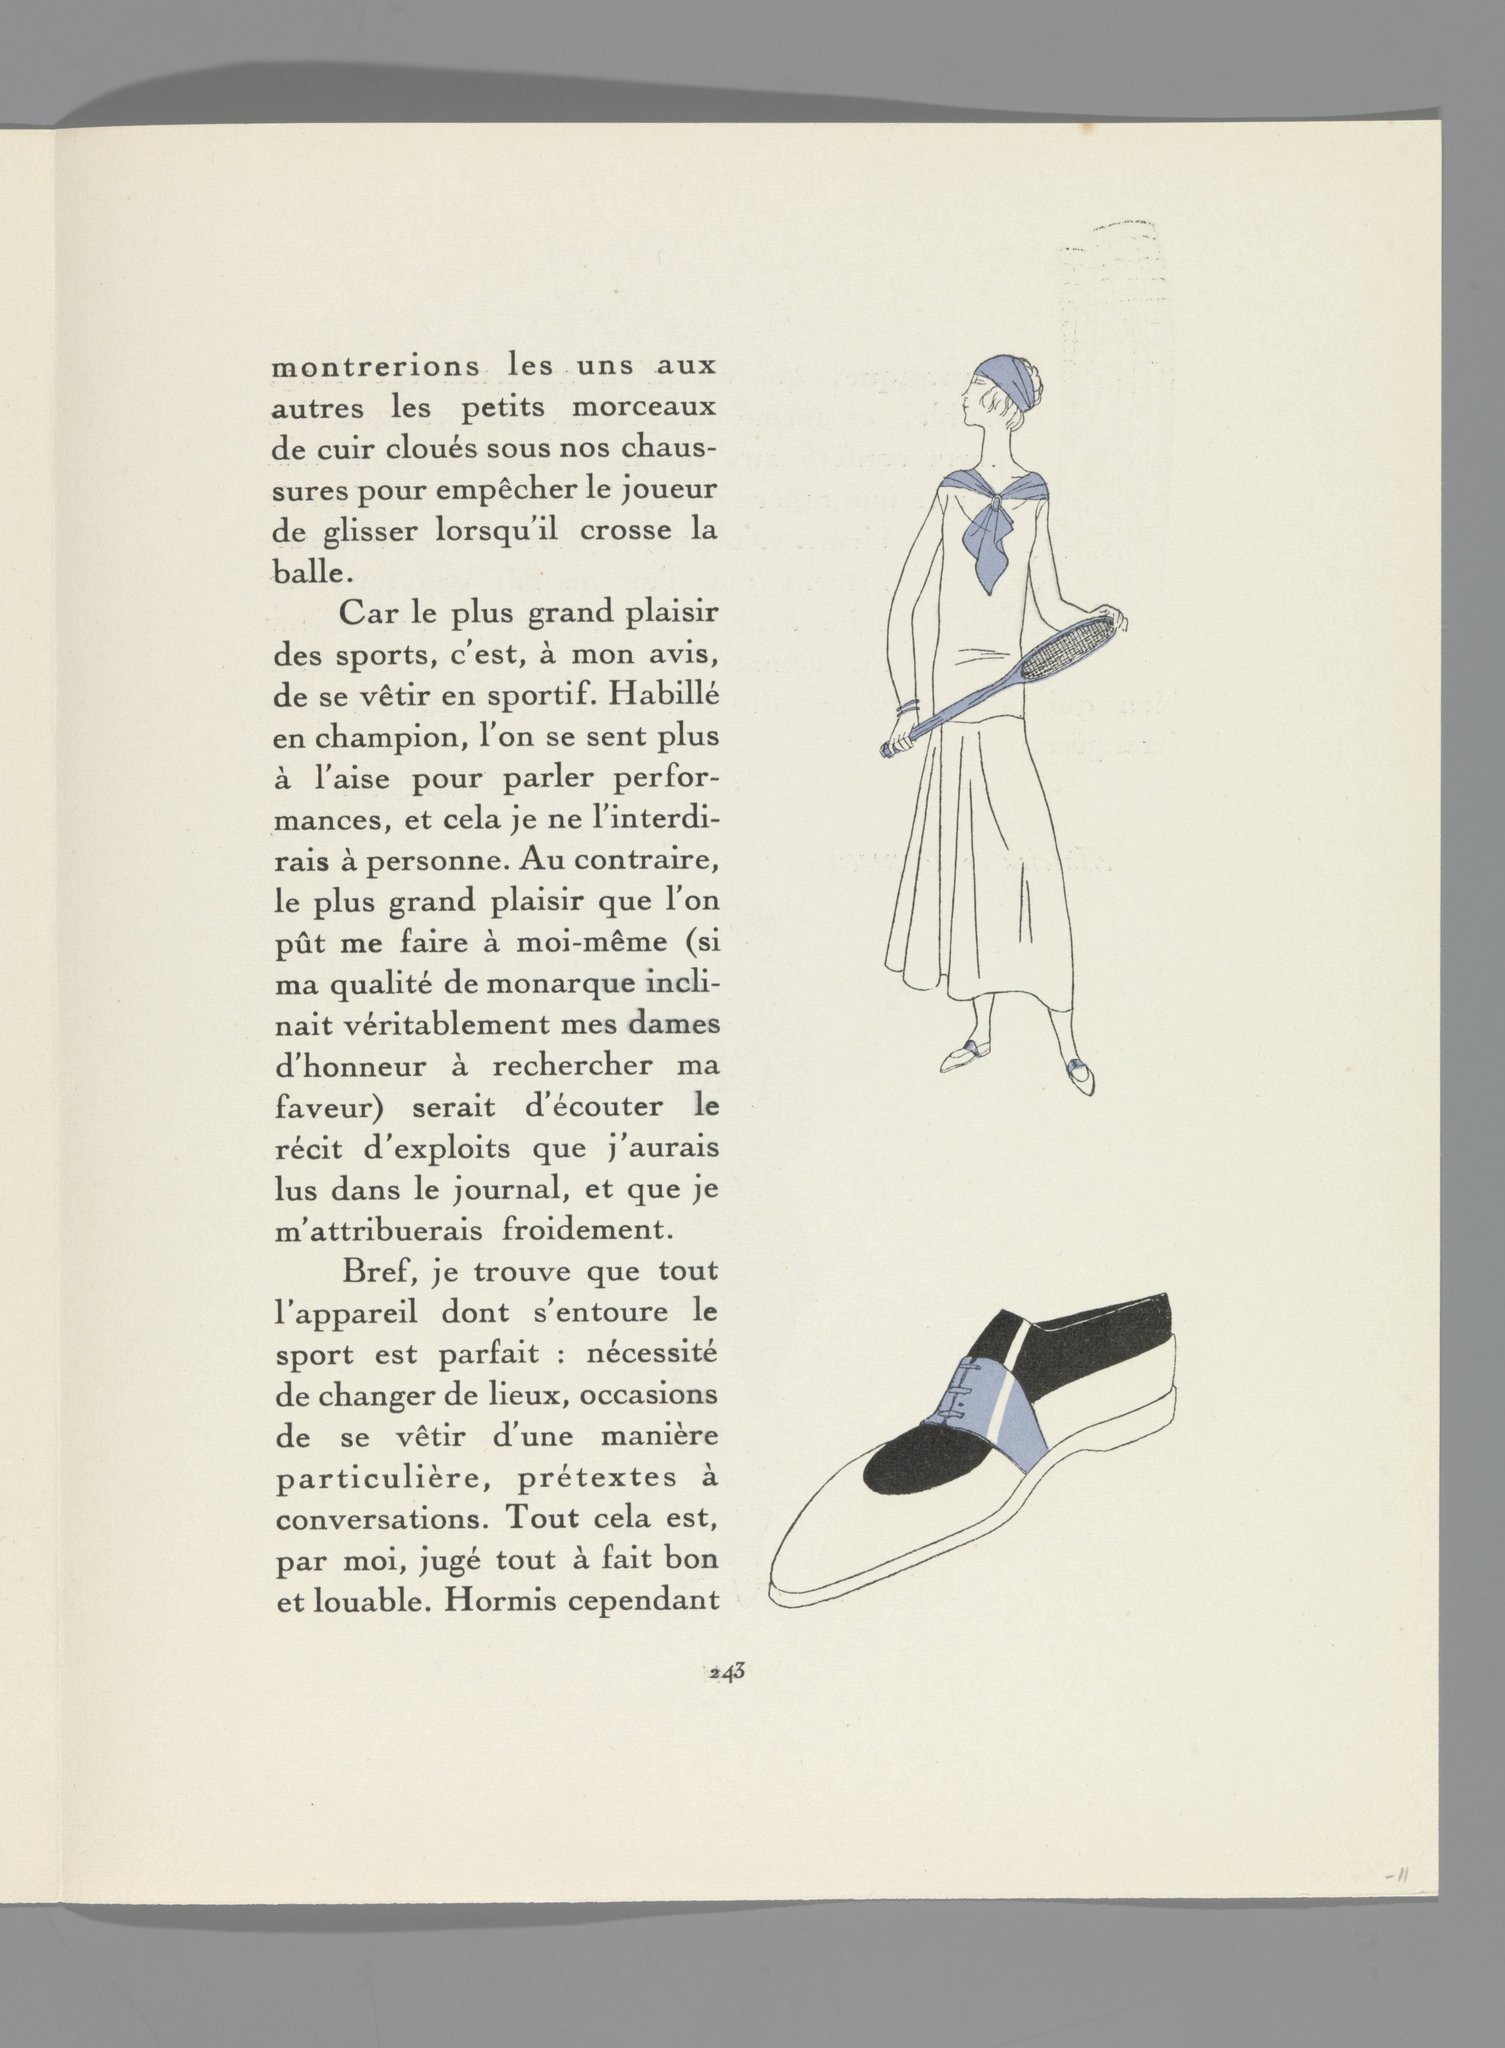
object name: fashion print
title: Gazette du Bon Ton, 1924 - No. 6 : p. 243: Chaussez-vous pour les Sports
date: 1924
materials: paper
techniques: letterpress printing, photochemical processes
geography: paris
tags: ear-rings (+ women's clothes), perfume bottle - aa - (for) women, perfumes - aa - (for) women, fashion plates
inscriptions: date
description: Tennisschoen en tenisster met racket in de hand.